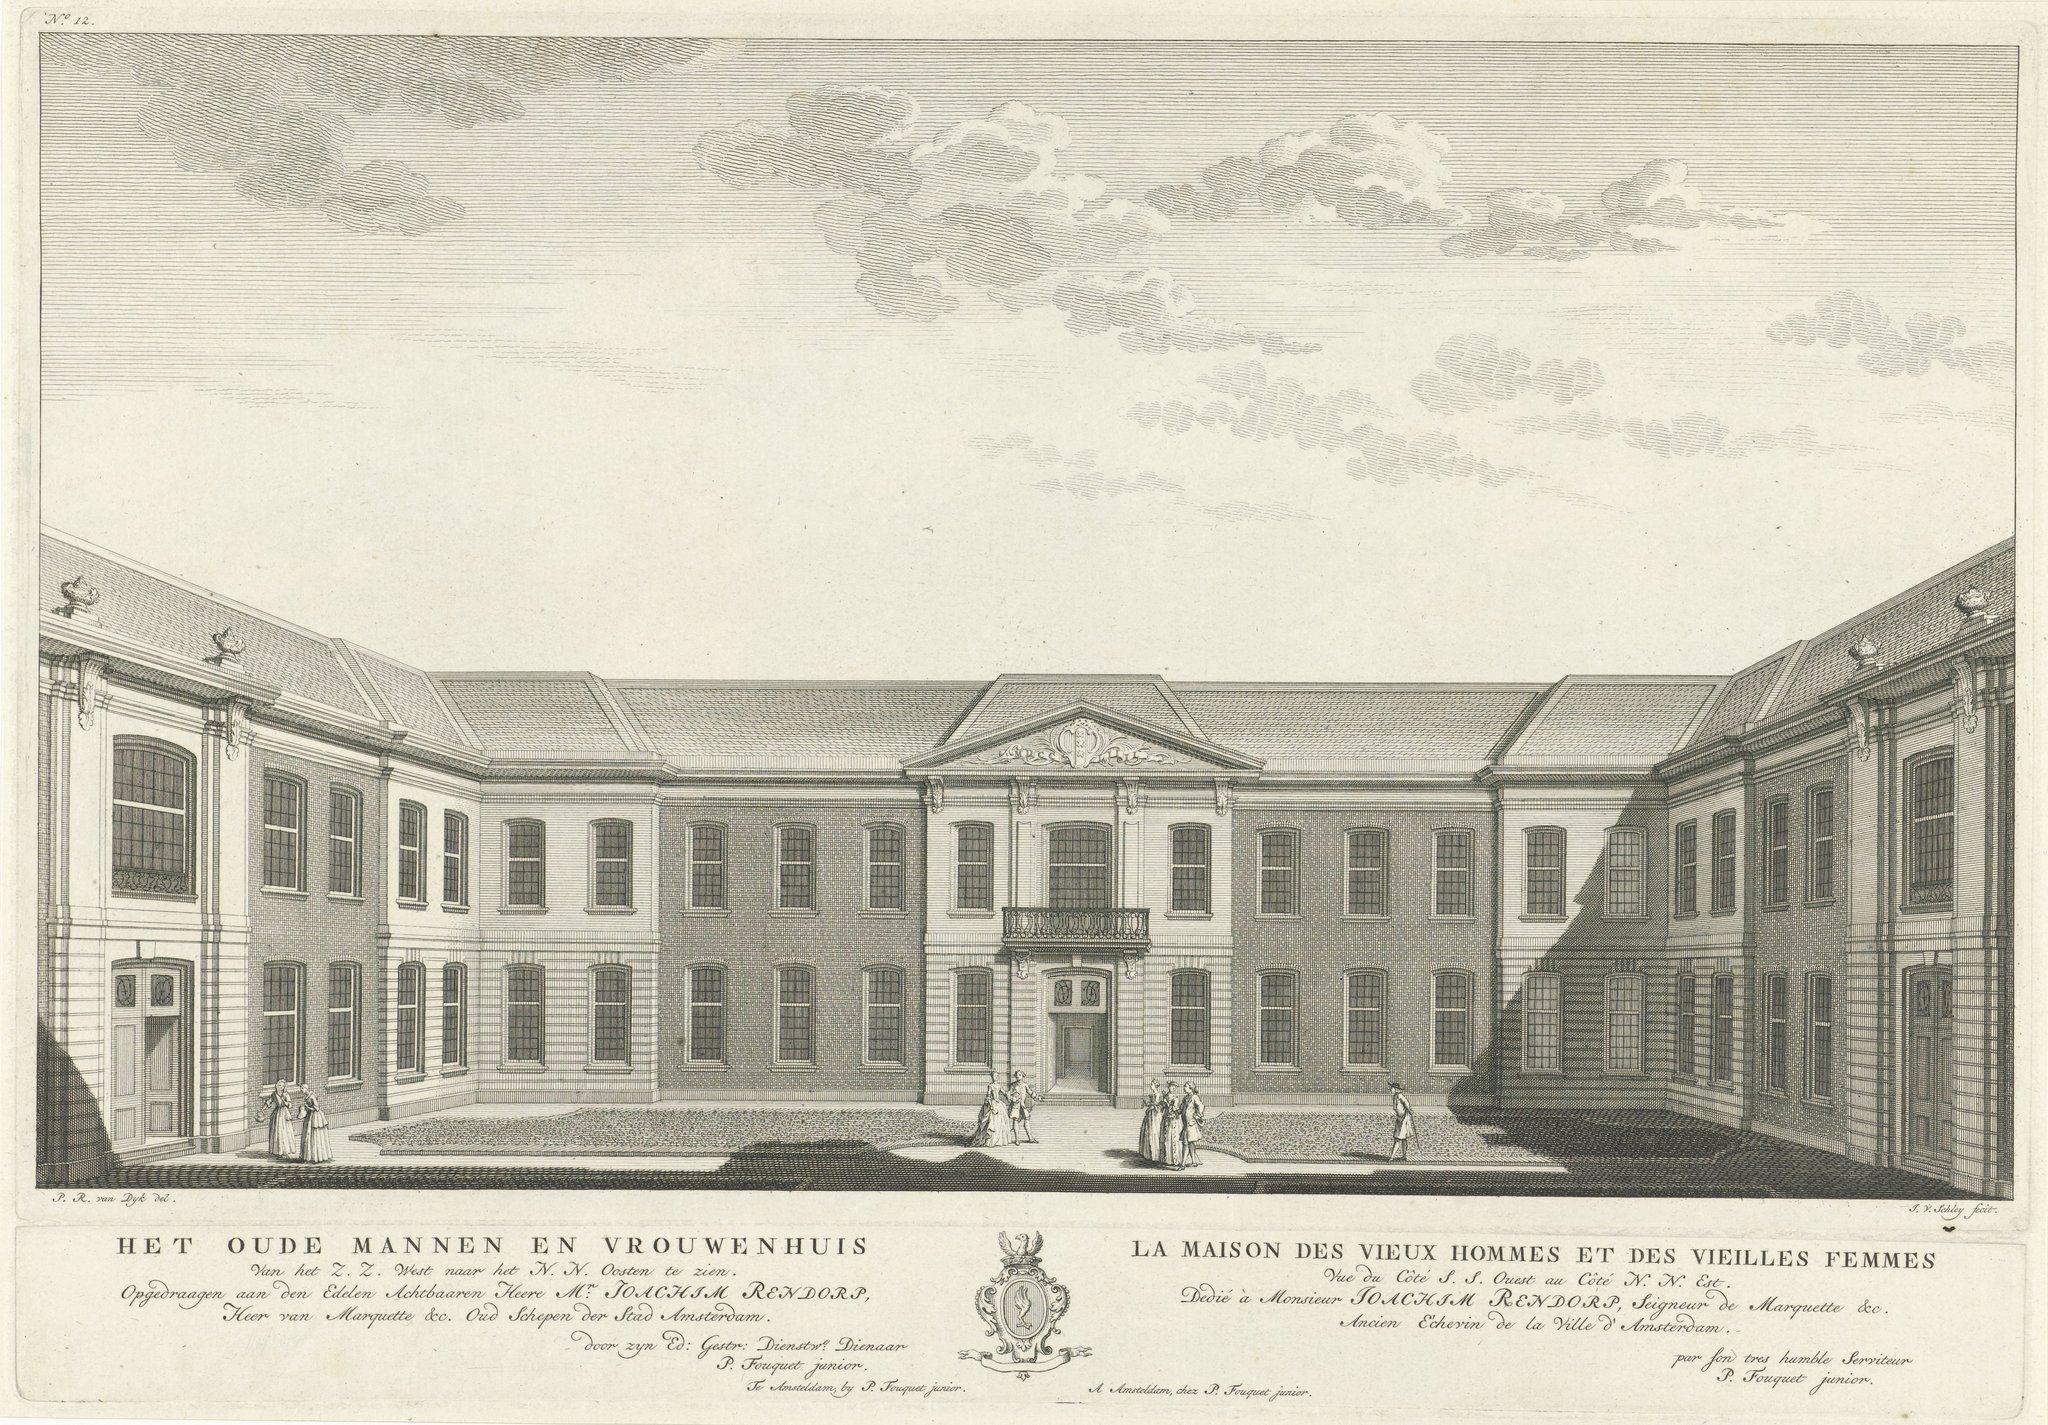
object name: print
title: Het Oude Mannen en Vrouwenhuis Van het Z.Z. West naar het N.N. Oosten te zien / La Maison des Vieux Hommes et des Vieilles Femmes Vue du Côté S.S. Ouest au Côté N.N. Est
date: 1760-1783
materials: paper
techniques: engraving, etching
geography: amsterdam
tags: amsterdam, mayor, joachim rendorp, public welfare, poorhouse, courtyard, armorial bearing, heraldry, old-people's home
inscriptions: collector's mark: Lugt 2233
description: Deze prent is ook gebruikt in de zogenaamde Atlas van Fouquet.* Pierre Fouquet gaf vanaf 1760 stadsgezichten van Amsterdam - naar tekeningen van verschillende kunstenaars, gemaakt door verschillende prentmakers - uit. Deze prenten werden aanvankelijk los of in series verkocht. Zoals toen gebruikelijk kon de koper de prenten zelf laten inbinden. Hiertoe gaf Fouquet tussen 1778 en 1783 een titelblad, plattegrond en inhoudsopgave van de tot dusver 100 uitgegeven prenten uit (1). Gezien de inhoud afhankelijk was van wat de koper had verzameld verschilt de inhoud van de verschillende bewaarde Fouquetatlassen onder deze titel sterk. Ook zijn er exemplaren bekend waar tevens andere prenten aan zijn toegevoegd. Omdat er behoefte bleek aan uitleg bij de platen werd in 1783 een nieuwe versie van de atlas uitgegeven, aangevuld met tekst en twee prenten. De aangegeven volgorde veranderde maar de platen van de al eerder uitgegeven prenten bleven ongewijzigd. Deze uitgave werd in opdracht van Fouquet gedrukt bij Daniël Jean Changuion en Petrus den Hengst (2). Een tiental platen werd bijgewerkt en verscheen, met nieuw impressum, in het vervolg van Wagenaars geschiedenis van Amsterdam, uitgeven door Petrus Conradi en Folkert van der Plaats (3). Een aantal jaar na het overlijden van Fouquet kwam Evert Maaskamp met een nieuwe uitgave van de atlas, met verbeterde tekst en toevoeging van twee prenten. Op alle platen verwijderde hij het oude en liet hij zijn eigen impressum zetten (4). De huidige staat van de prent komt voor in exemplaren van de onder (1) en (2) genoemde werken. * Onder de Atlas van Fouquet of Fouquetatlas verstaan we de hieronder vermelde publicaties (1), (2) en (4). (1). Afbeeldingen van de wyd-vermaarde koopstad Amsterdam benevens des zelvs voornaamste gebouwen en gezigten alle naar het leeven getekend / Receuil des edifices les plus considerables et des plus belles vues, de la fameuse ville d'Amsterdam, dessinées d'après nature. Amsterdam: Pierre Fouquet, 1778-1783. (2). Nieuwe atlas, van de voornaamste gebouwen en gezigten der stad Amsterdam, met derzelver beknopte beschryvingen. 2 delen. Amsterdam: Daniël Jean Changuion en Petrus den Hengst [in opdracht van Pierre Fouquet], 1783. (3). Stijl, Simon. Amsterdam, in zyne geschiedenissen, voorregten, koophandel, gebouwen, kerkenstaat, schoolen, schutterye, gilden en regeeringe, beschreeven. Om te dienen ten vervolge op het werk van Jan Wagenaar (…). 10 delen. Amsterdam en Harlingen: Petrus Conradi en Folkert van der Plaats, 1788-1801. (4). Nieuwe atlas, van de voornaamste gebouwen en gezigten der stad Amsterdam. Met derzelver beknopte beschryvingen. Amsterdam: Evert Maaskamp, 1805. * Het aantal vermelde staten is gebaseerd op het aantal gevonden staten. Mogelijk zijn er meer staten van deze prent.